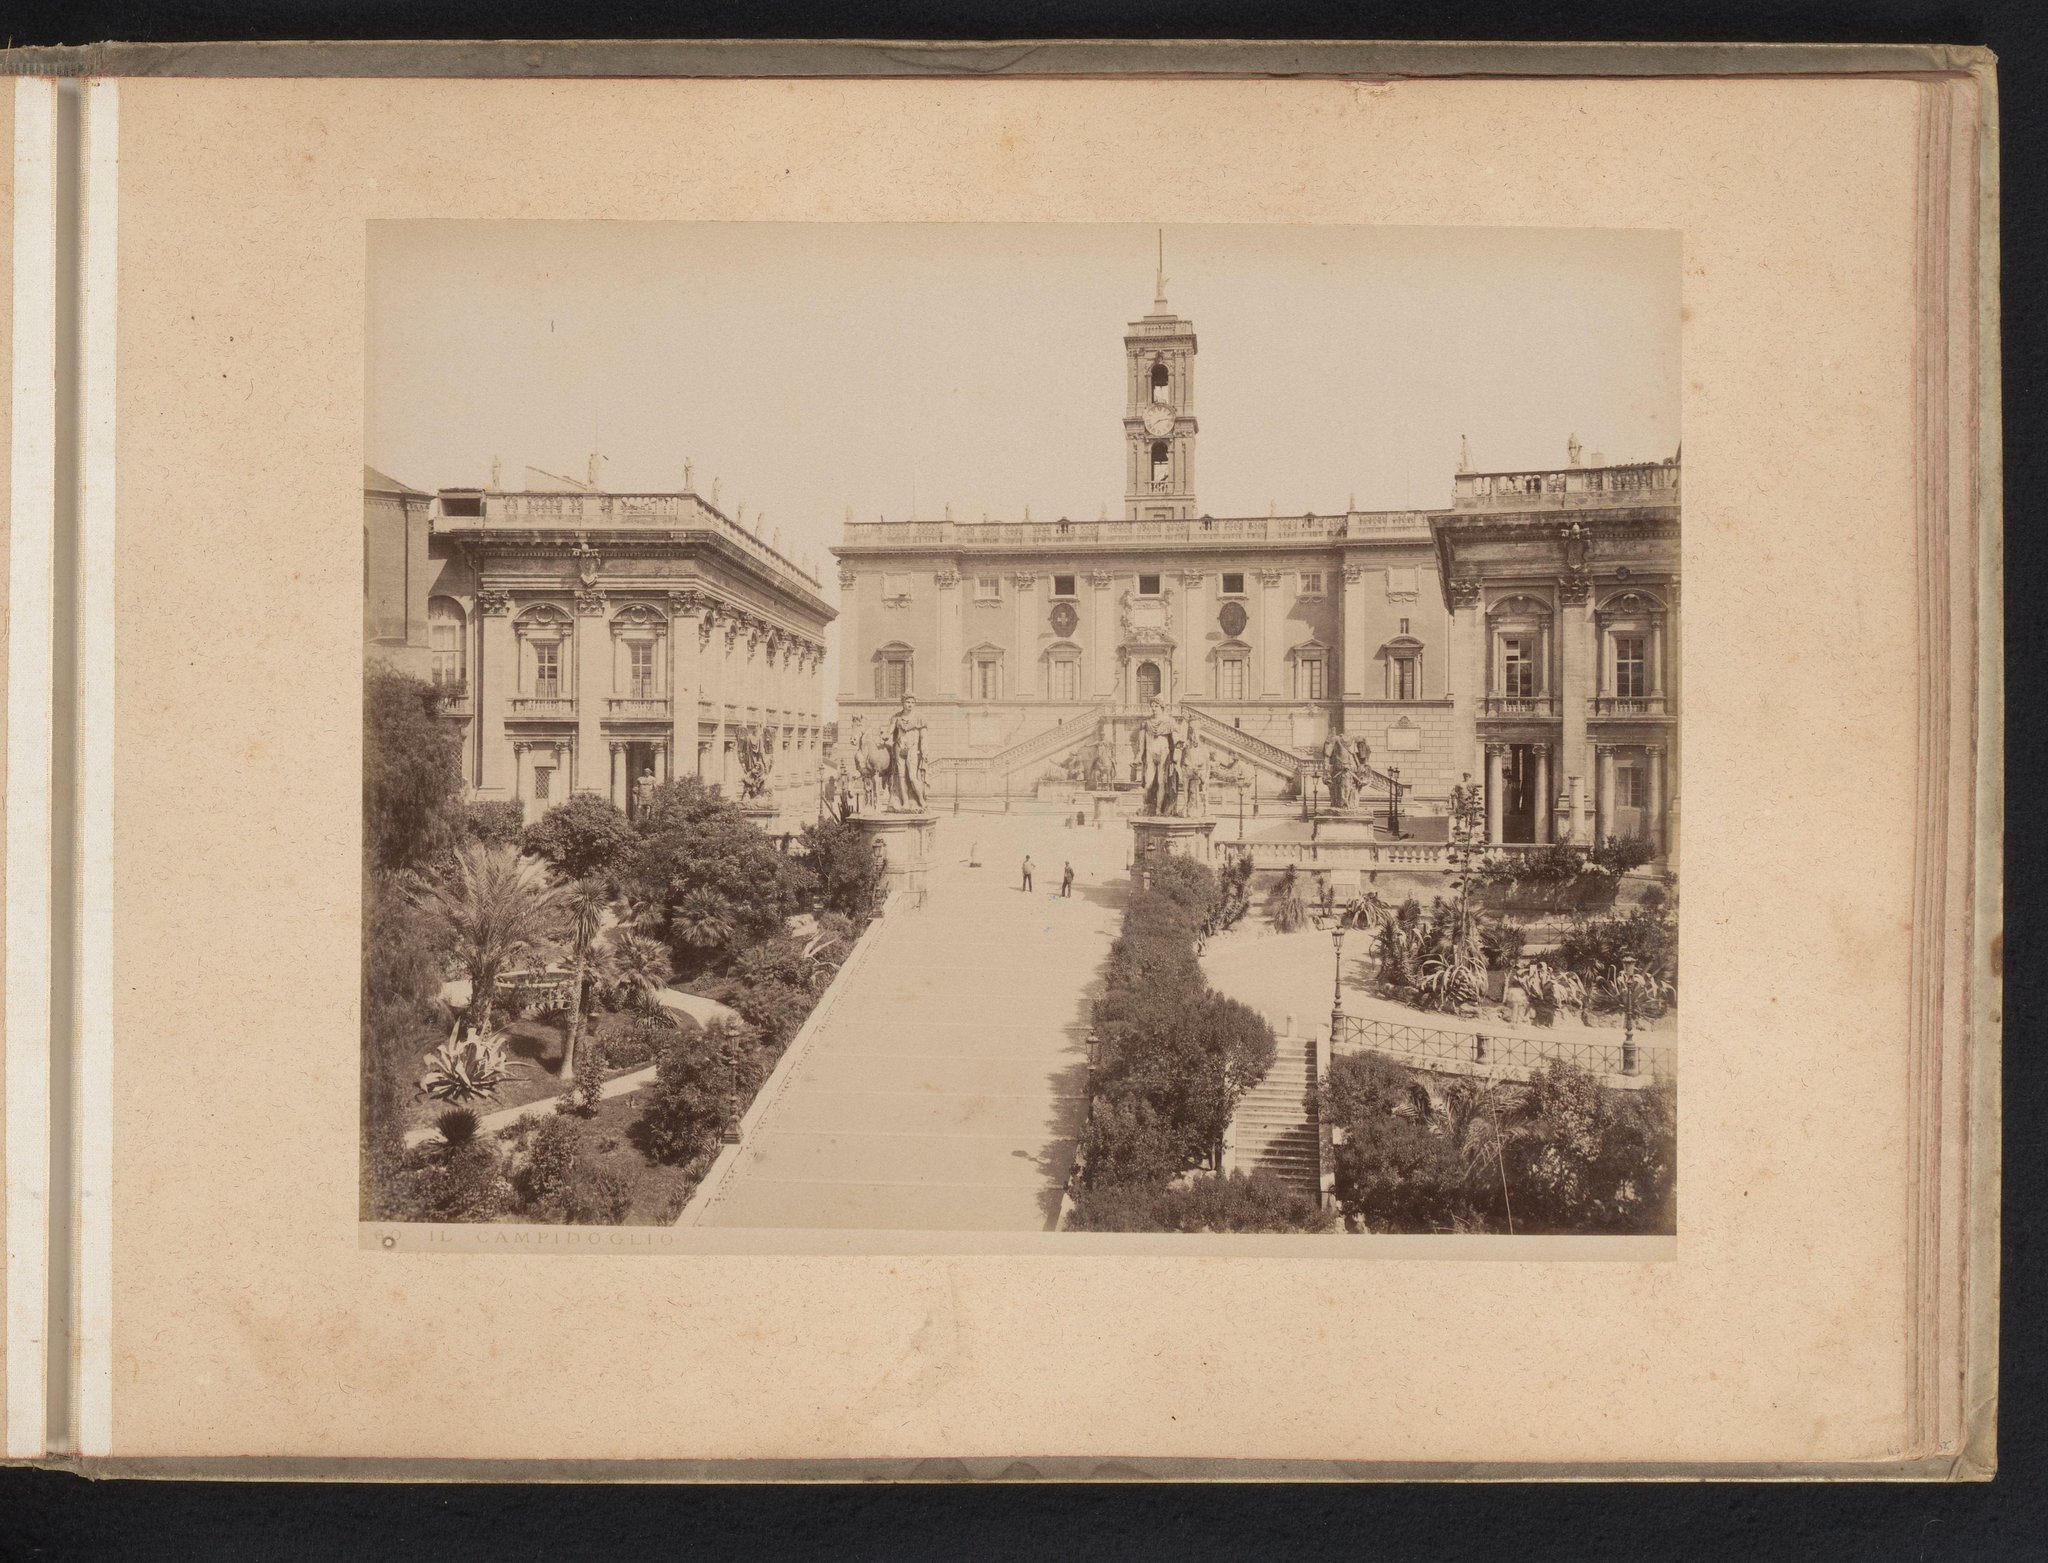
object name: photograph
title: Gezicht op het Capitool in Rome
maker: Anonymous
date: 1870-1895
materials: cardboard, photographic support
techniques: albumen print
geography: rome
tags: square, place, circus, etc., palace, prospect of city, town panorama, silhouette of city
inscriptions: inscription: ‘60 IL CAMPIDOGLIO’